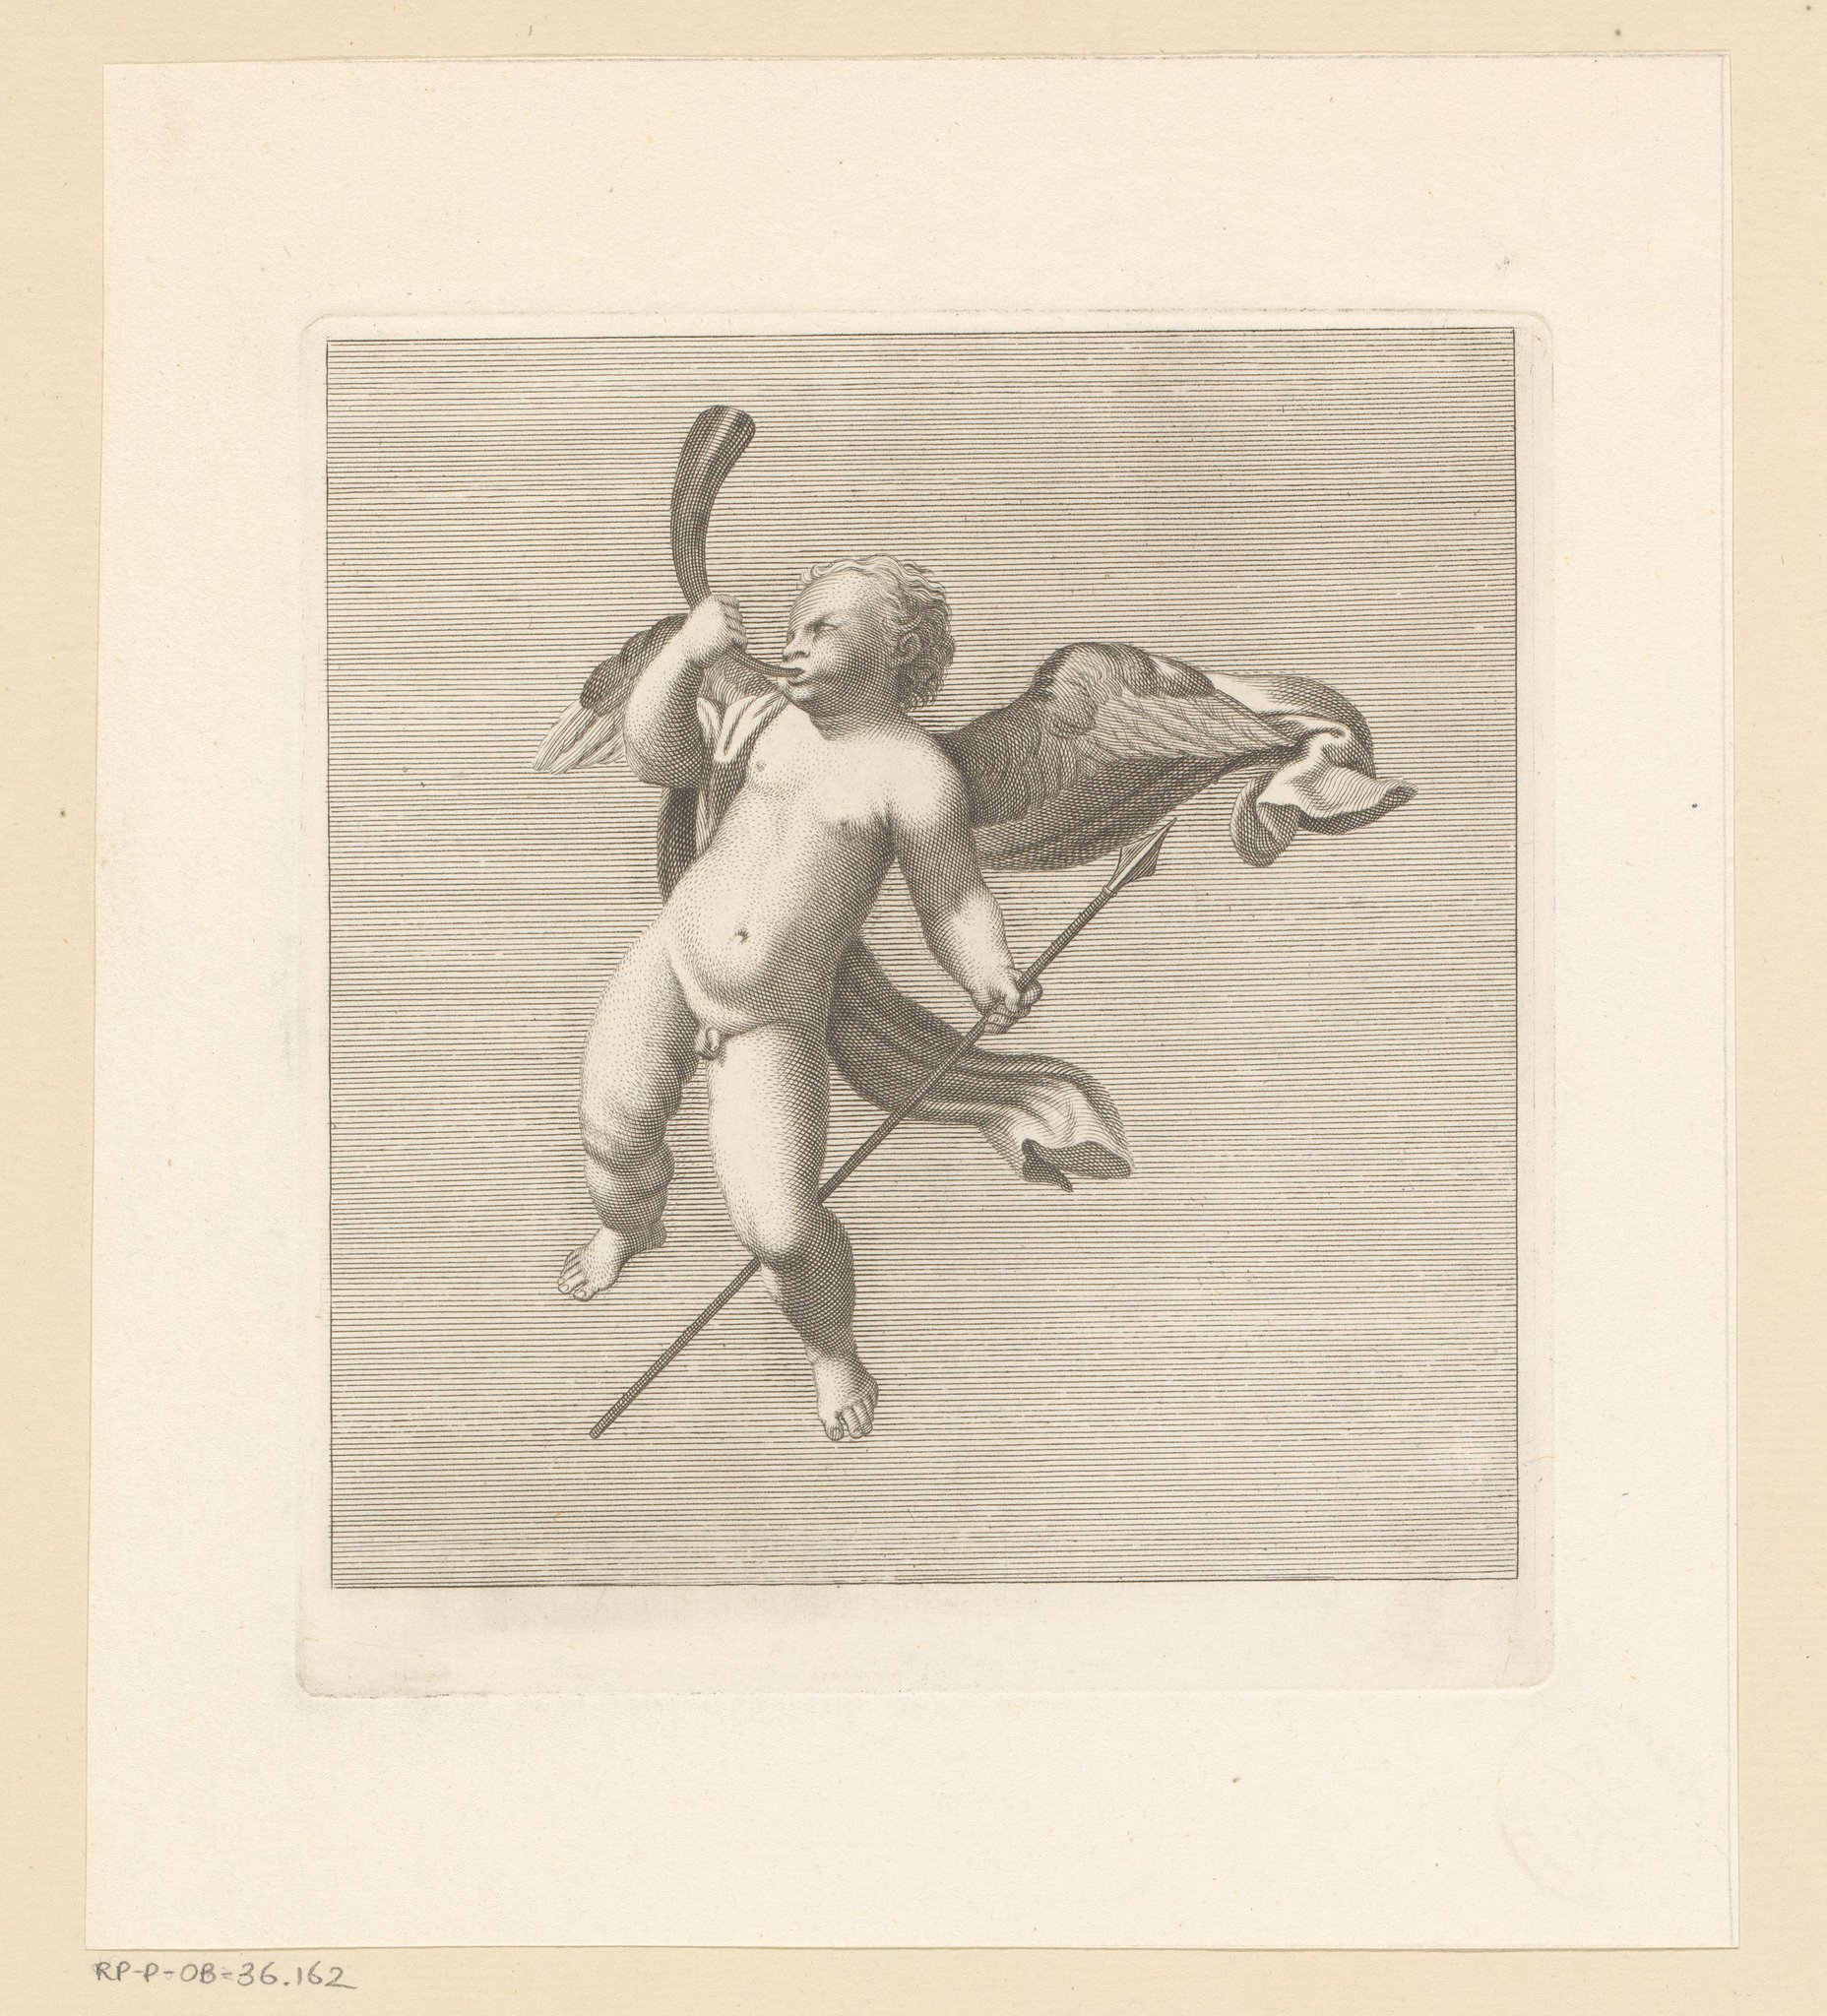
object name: print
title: Het leven van Diana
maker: giovanni girolamo frezza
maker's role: print maker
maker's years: 1659-1748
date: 1713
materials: paper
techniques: engraving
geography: italy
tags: (story of) cupid, amor (eros), cupids: 'amores', 'amoretti', 'putti'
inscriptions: collector's mark: Lugt 240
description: Naar een fresco door Domenichino in het Palazzo Giustiniani-Odescalchi in Bassano di Sutri. Prent uit een reeks prenten met als onderwerp het leven van Diana.